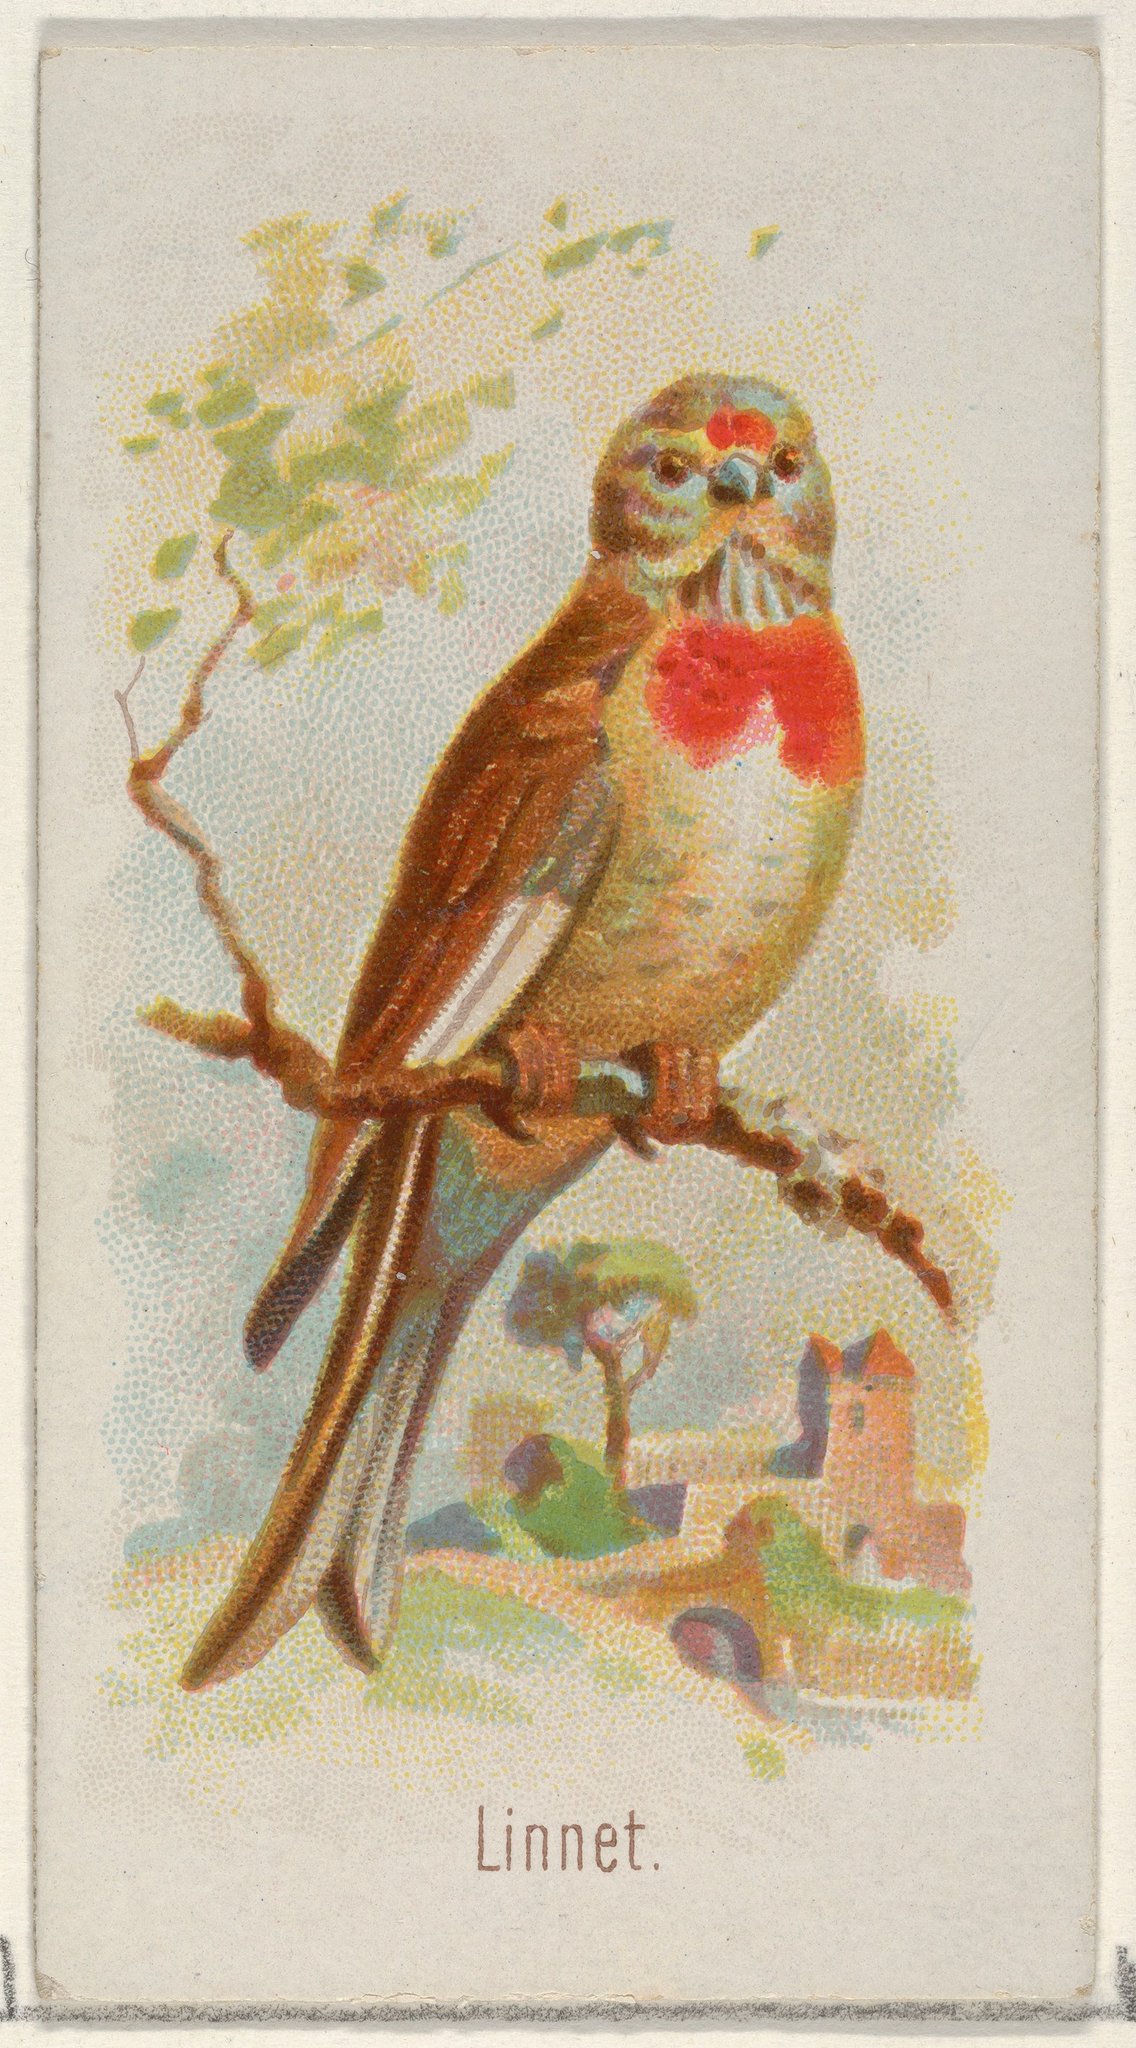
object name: print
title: Linnet, from the Song Birds of the World series (N23) for Allen & Ginter Cigarettes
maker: allen & ginter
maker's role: publisher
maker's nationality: american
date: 1890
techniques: color lithograph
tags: birds